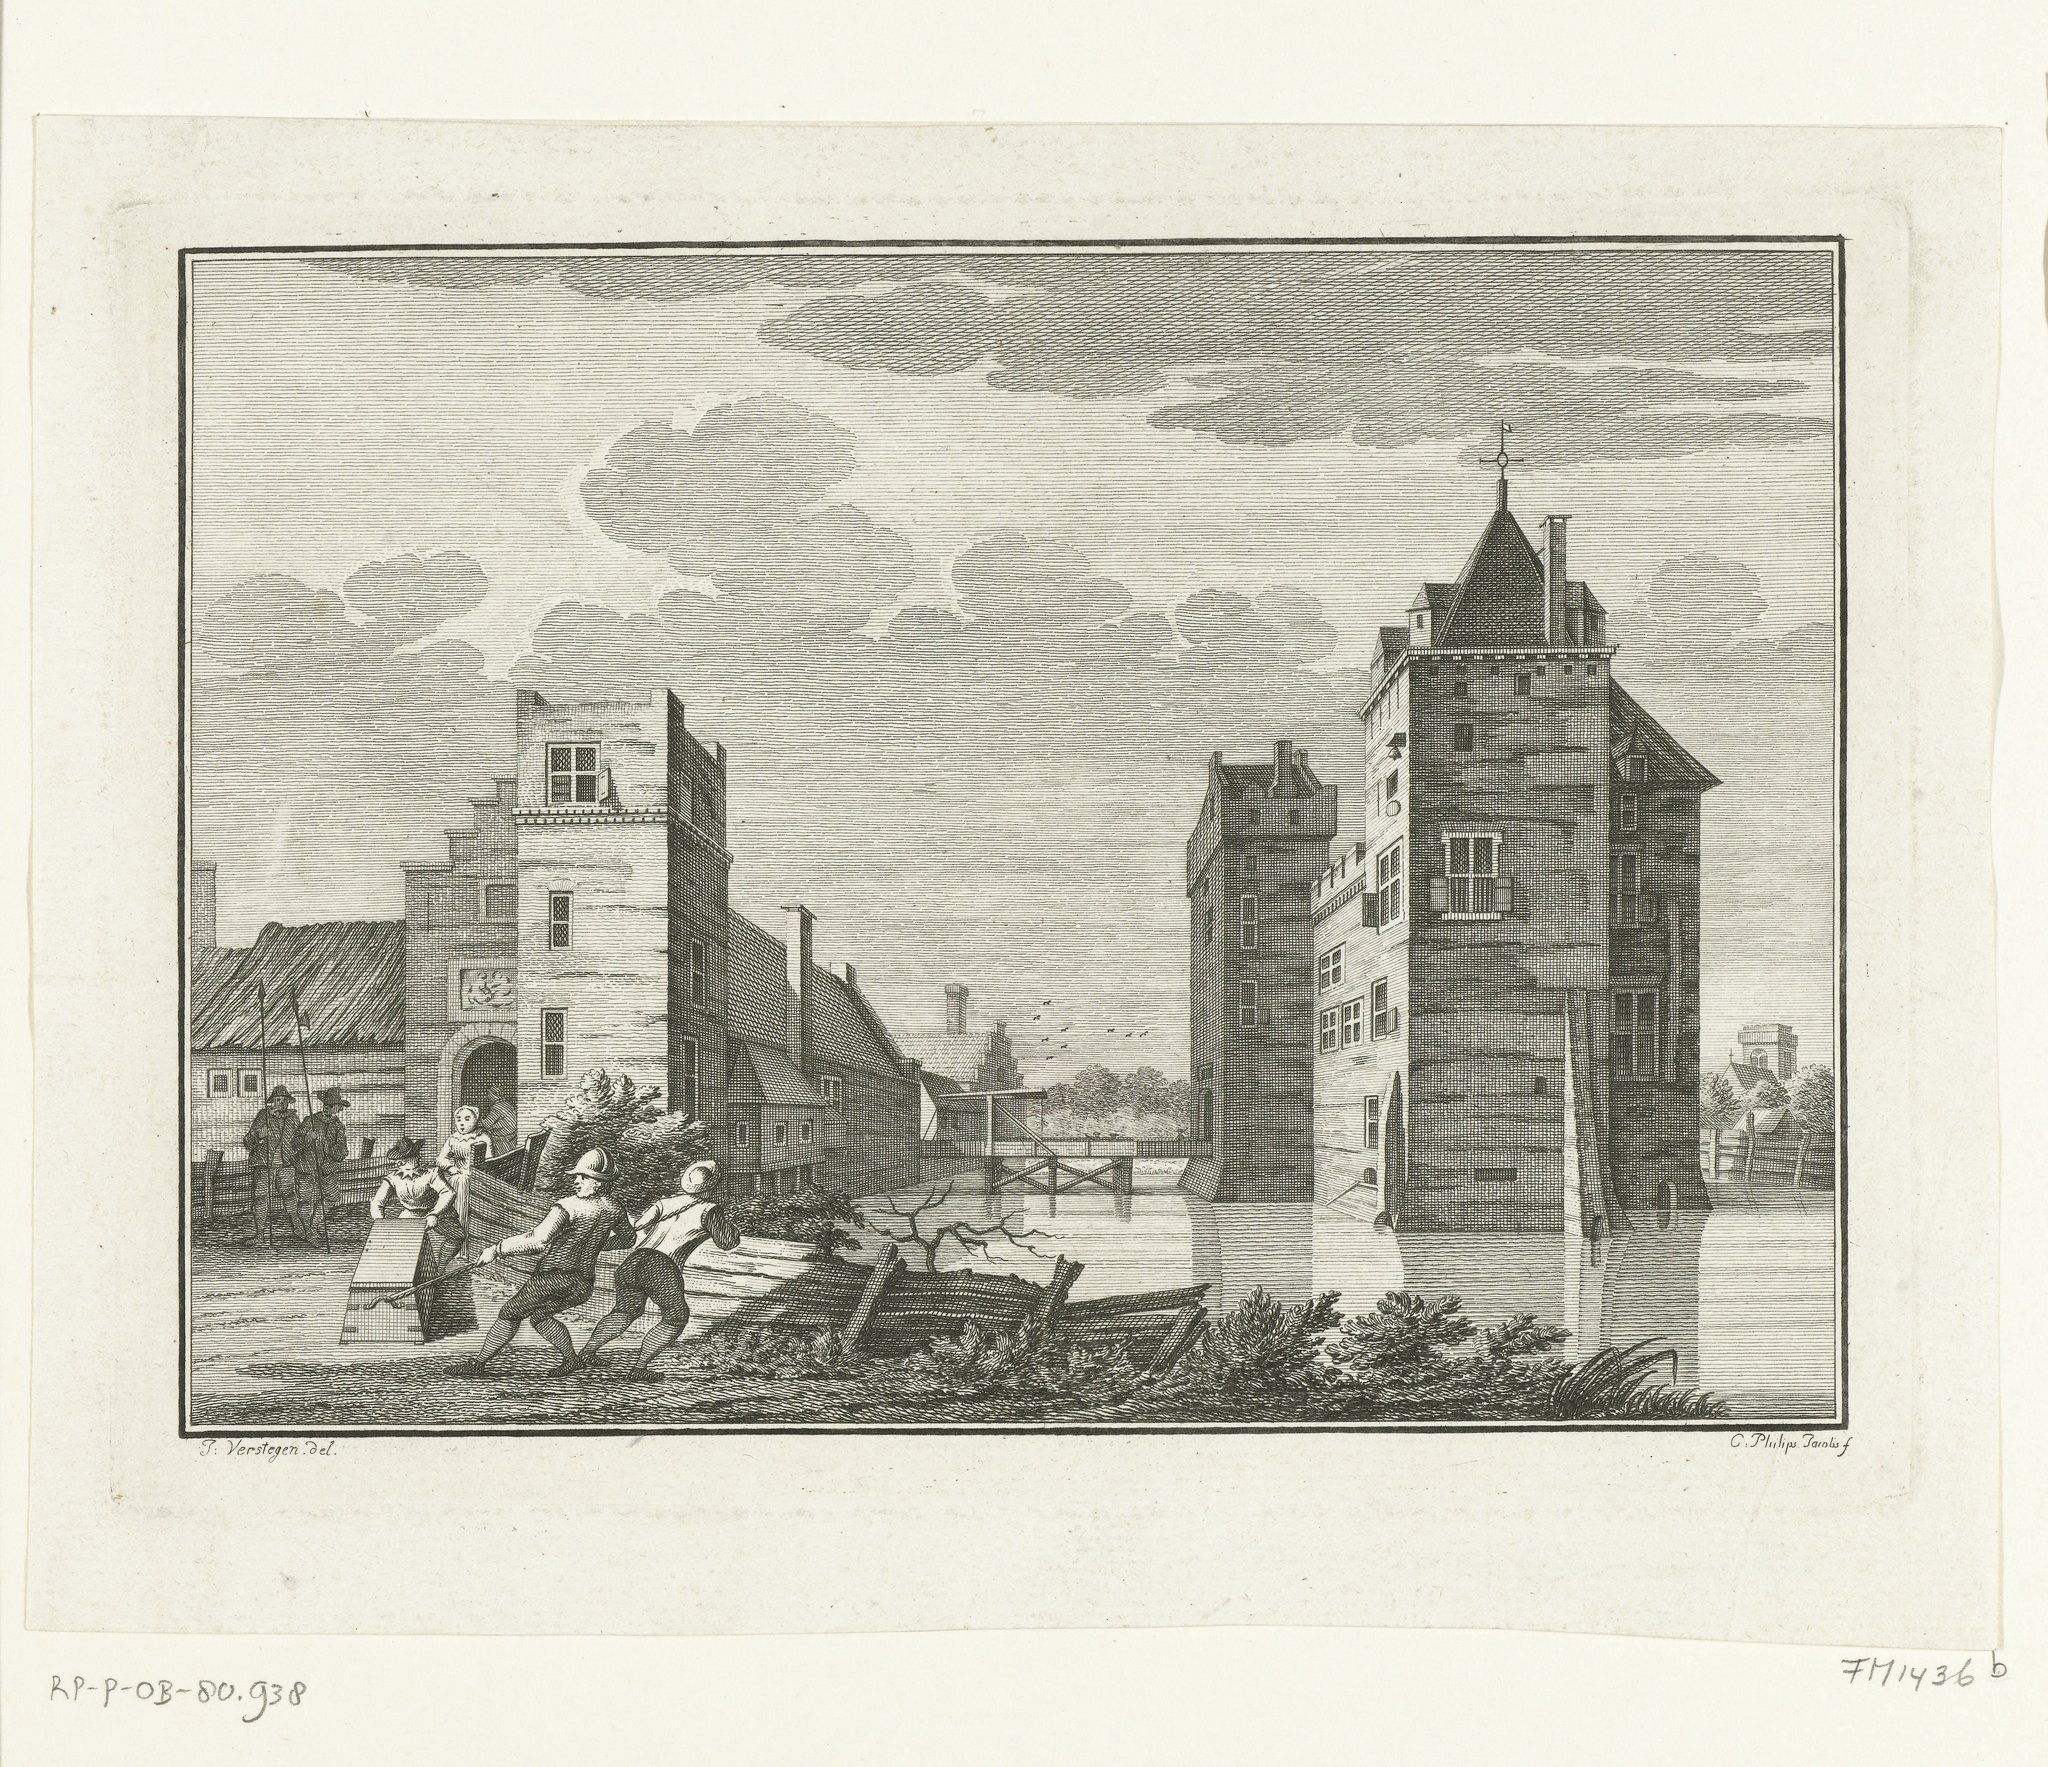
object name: history print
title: Ontsnapping van Hugo de Groot in de boekenkist uit Slot Loevestein, 1621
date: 1752-1789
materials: paper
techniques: etching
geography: amsterdam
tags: delft, hugo de groot, castle, law and jurisprudence (+ escape from prison), loevestein castle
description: Gezicht op Slot Loevestein met links op de voorgrond de ontsnapping van Hugo de Groot in de boekenkist, 22 maart 1621. Mannen slepen de kist aan een touw.